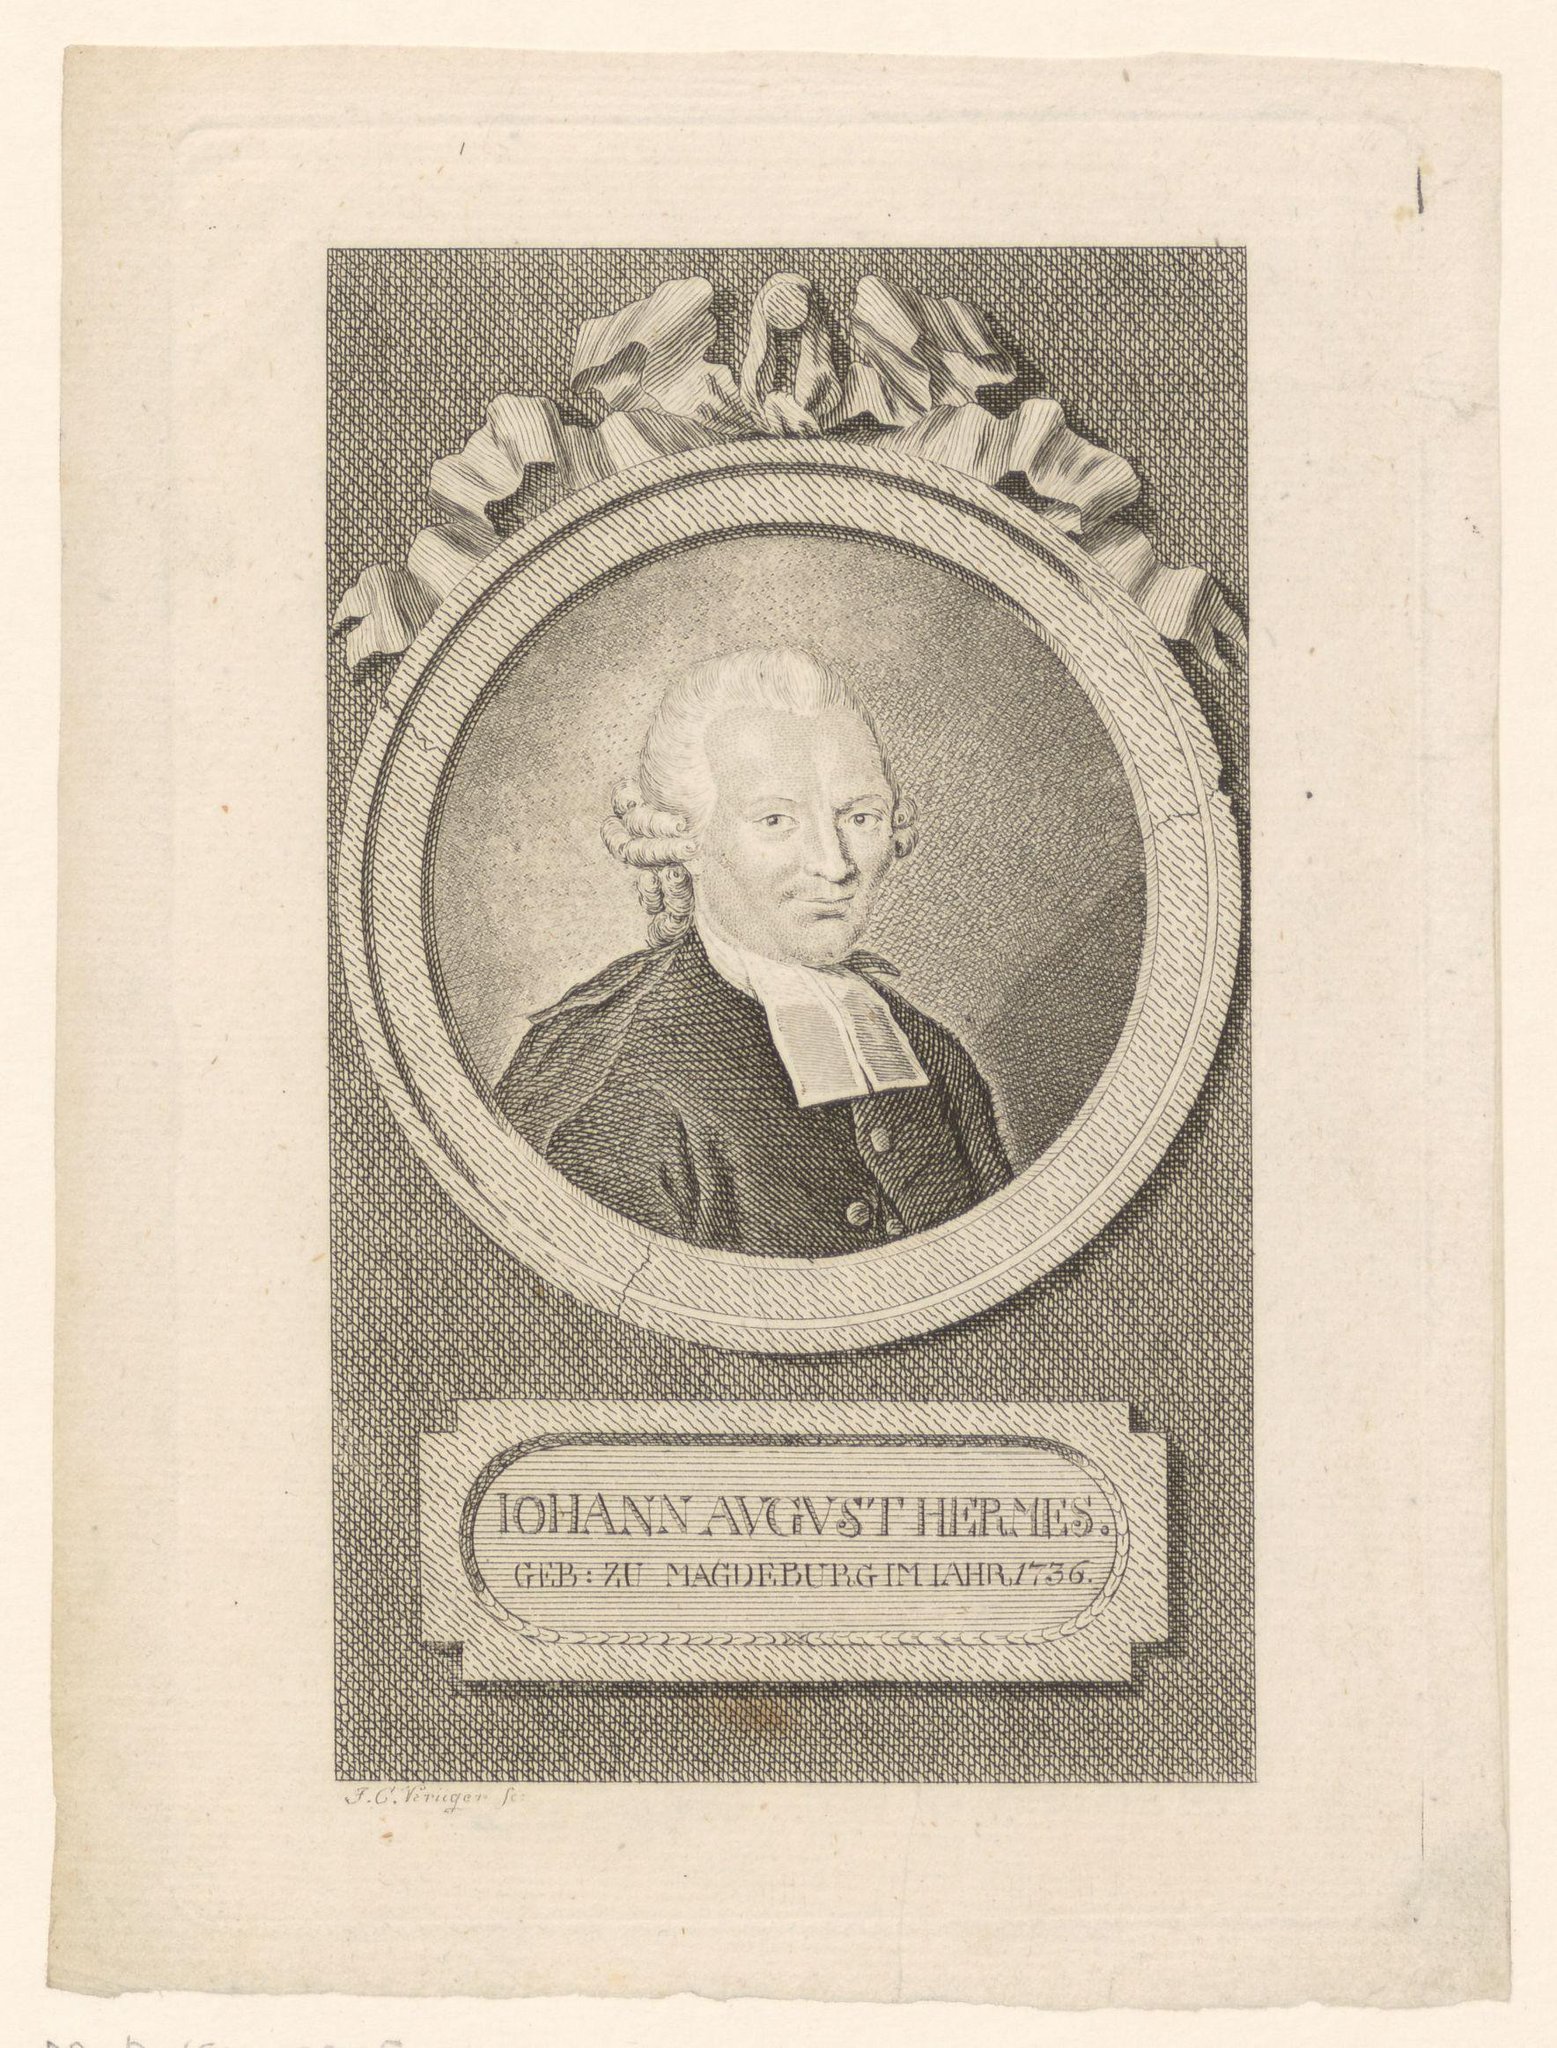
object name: print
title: Portret van Johann August Hermes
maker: johann conrad krüger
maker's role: artist, painter, print maker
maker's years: 1733-1791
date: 1743-1791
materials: paper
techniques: engraving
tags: theologian, historical persons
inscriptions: collector's mark: Lugt 2228